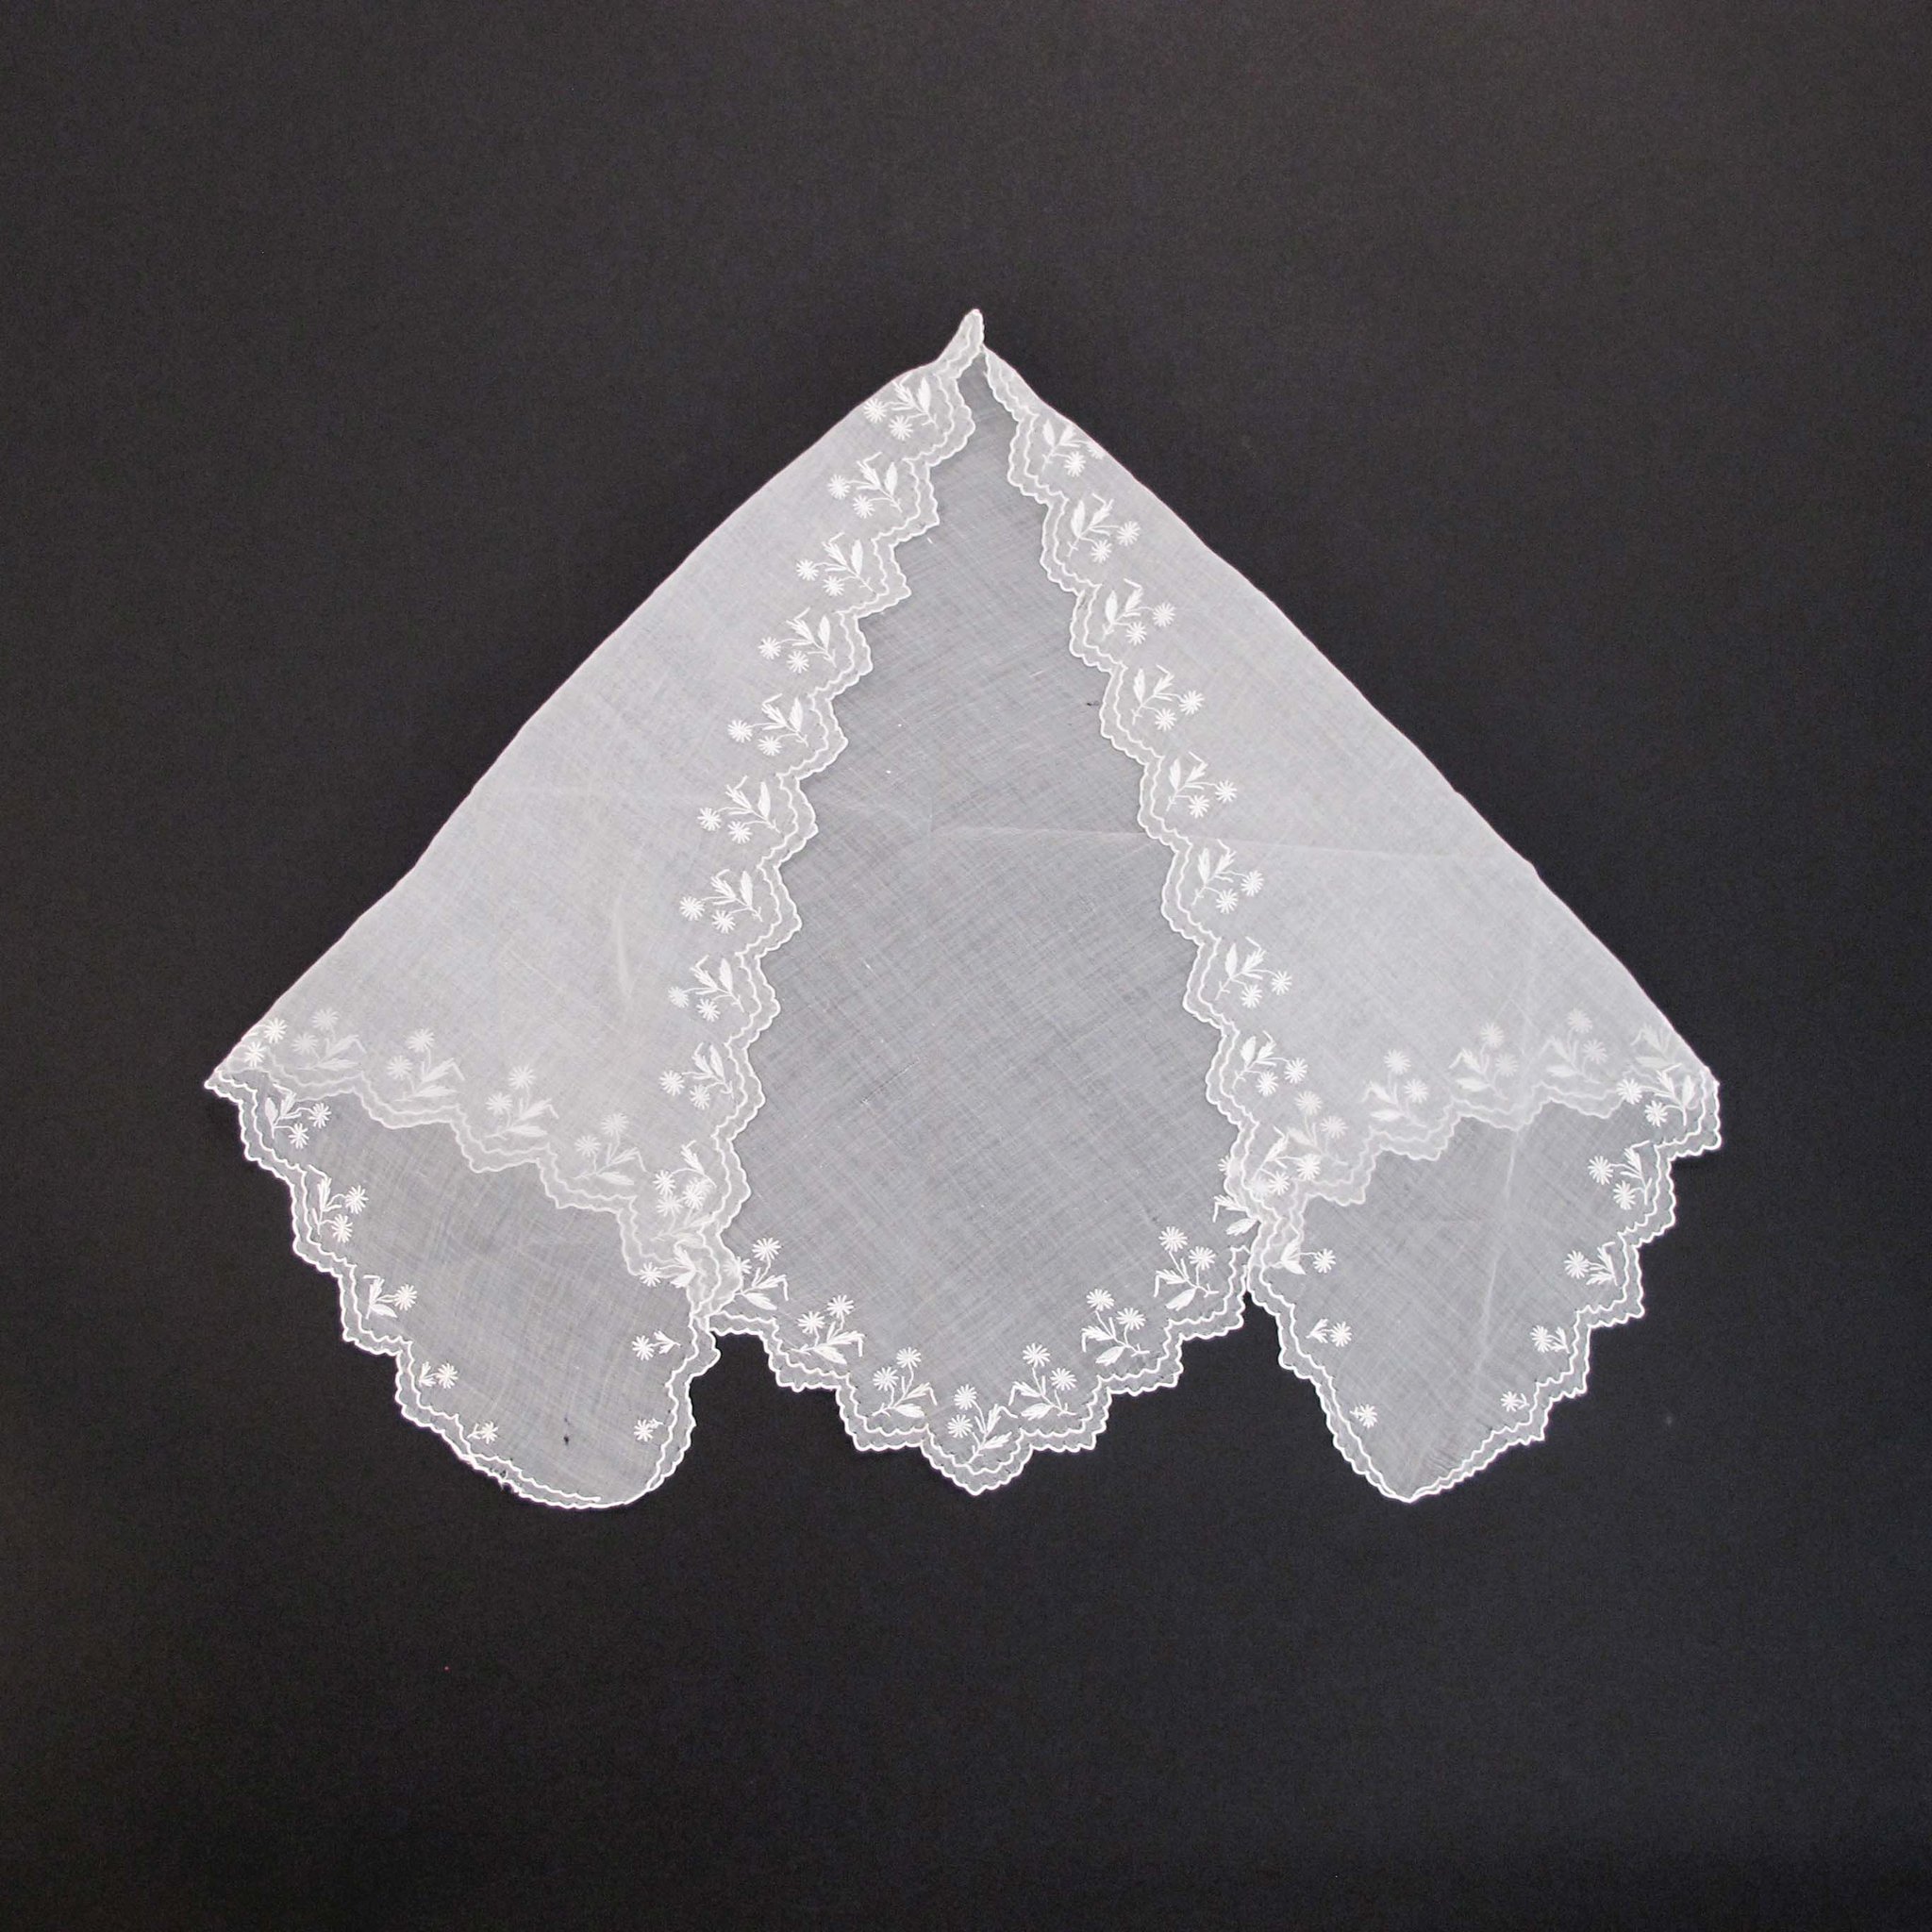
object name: kerchief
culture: french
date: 1825-1835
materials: cotton